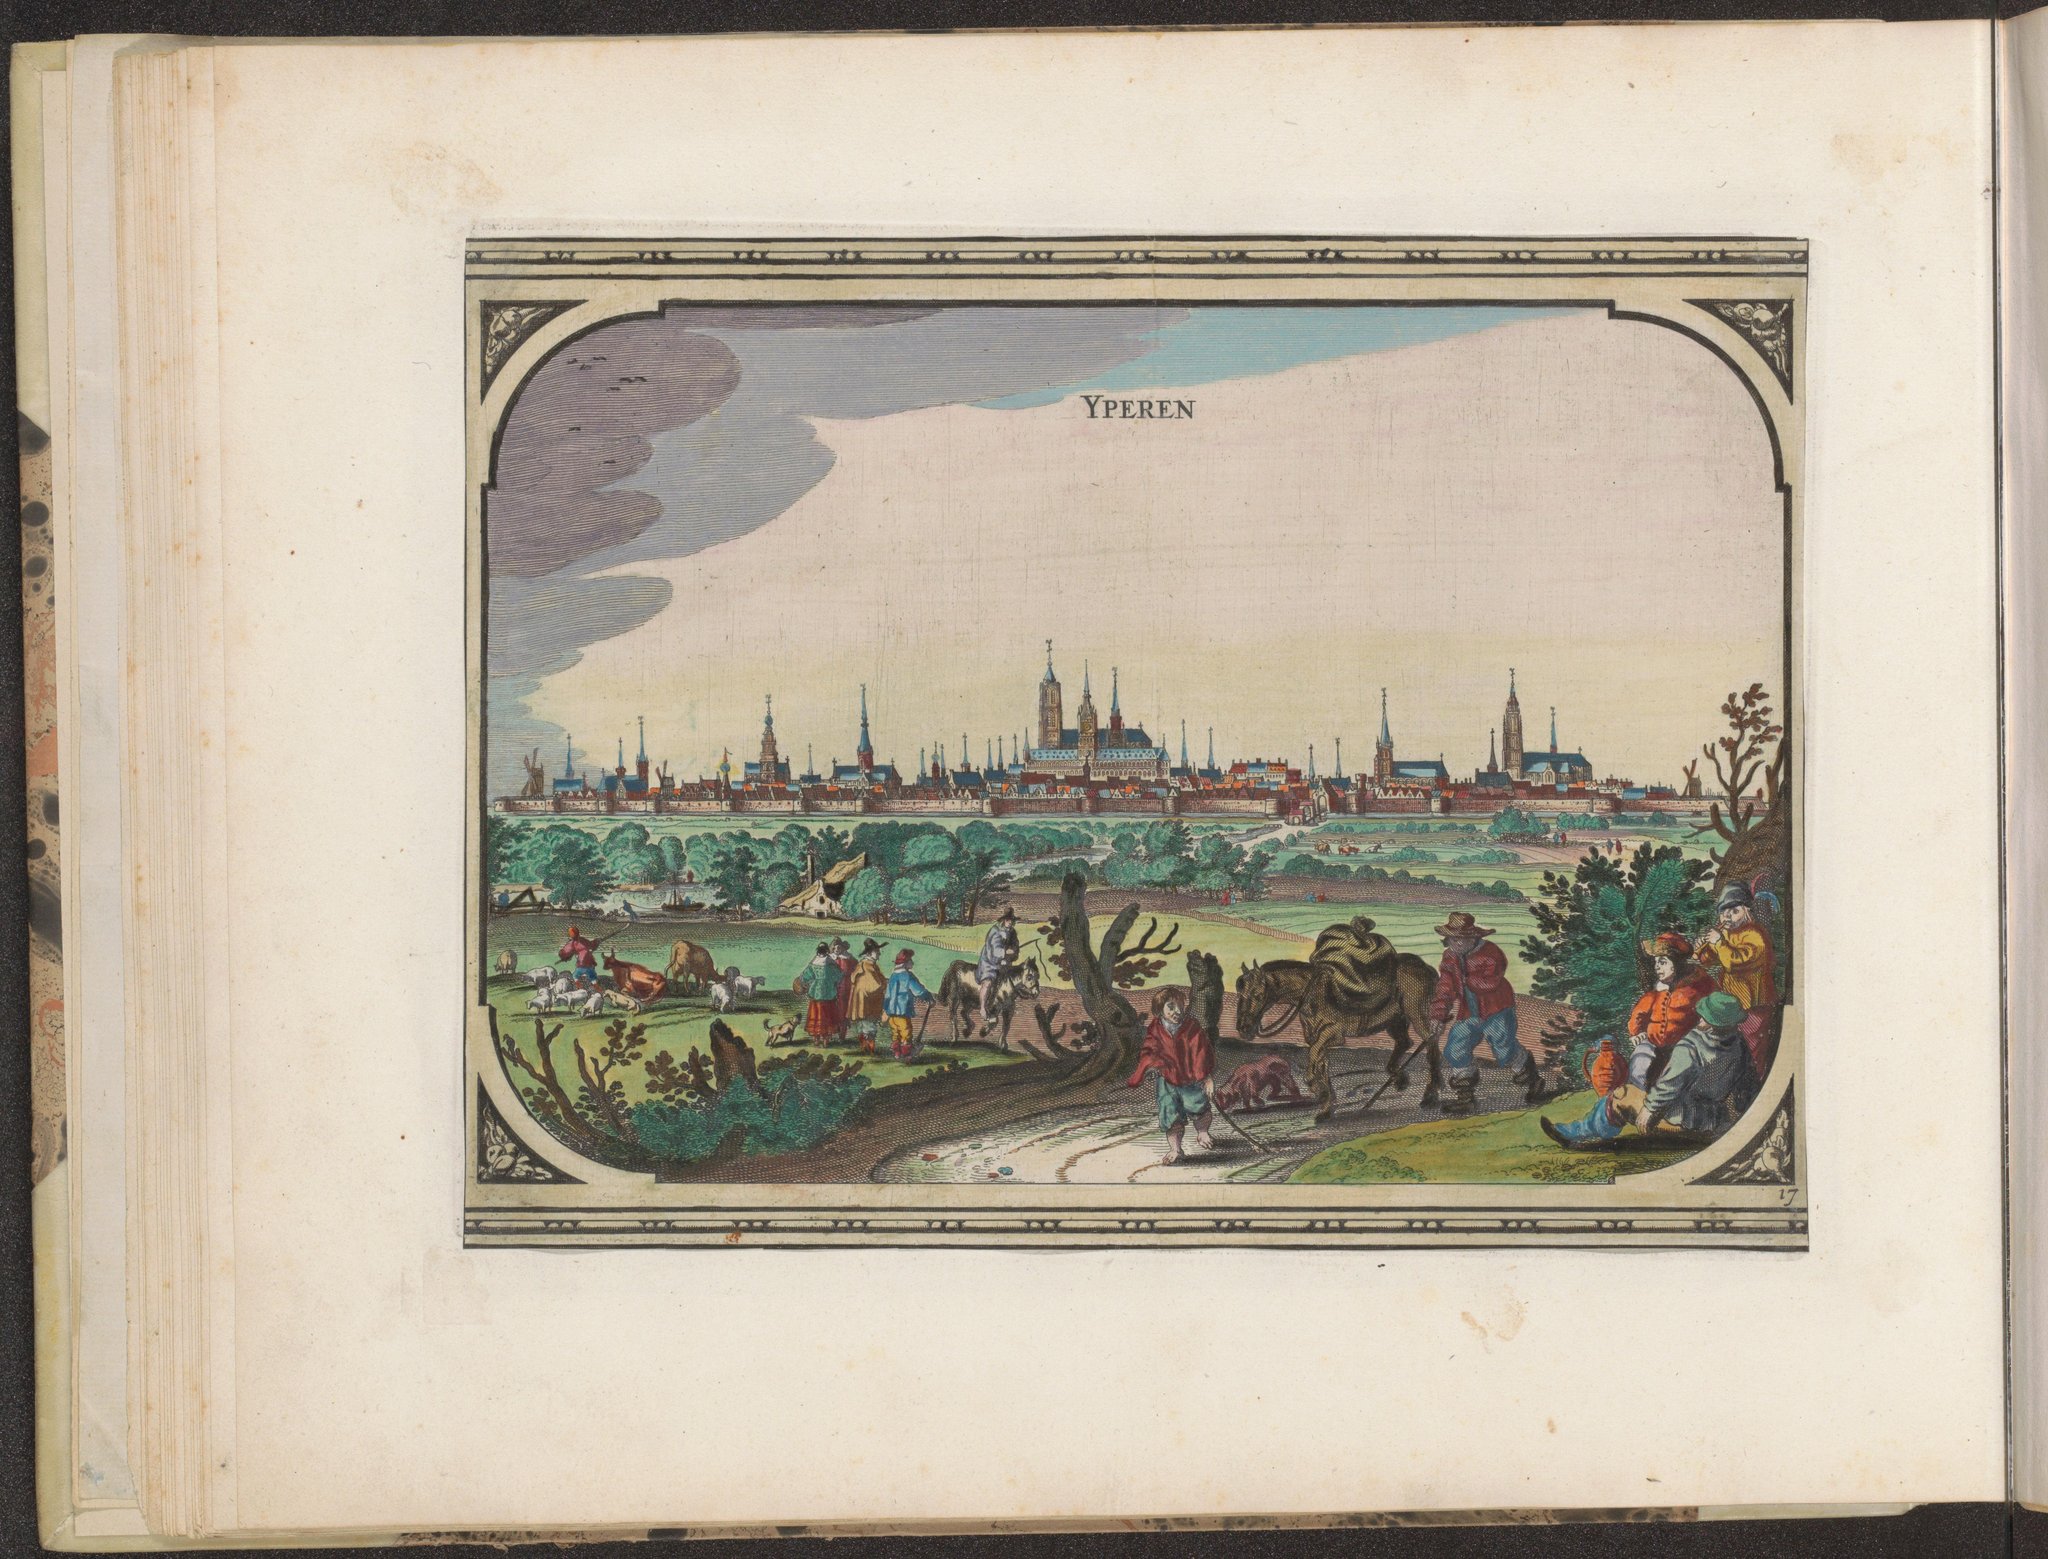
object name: album leaf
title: Yperen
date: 1657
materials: paper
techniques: etching, hand coloring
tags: city-view, and landscape with man-made constructions, 'en route', traveller under way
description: Gezicht op de stad Ieper. Drie personen, één speelt er muziek, kijken naar enkele reizigers die langskomen. Op de rug van een paard ligt een grote zak. Een jongen trekt een boomtak achter zich aan. Links een herder met zijn kudde. De prent maakt deel uit van een album.